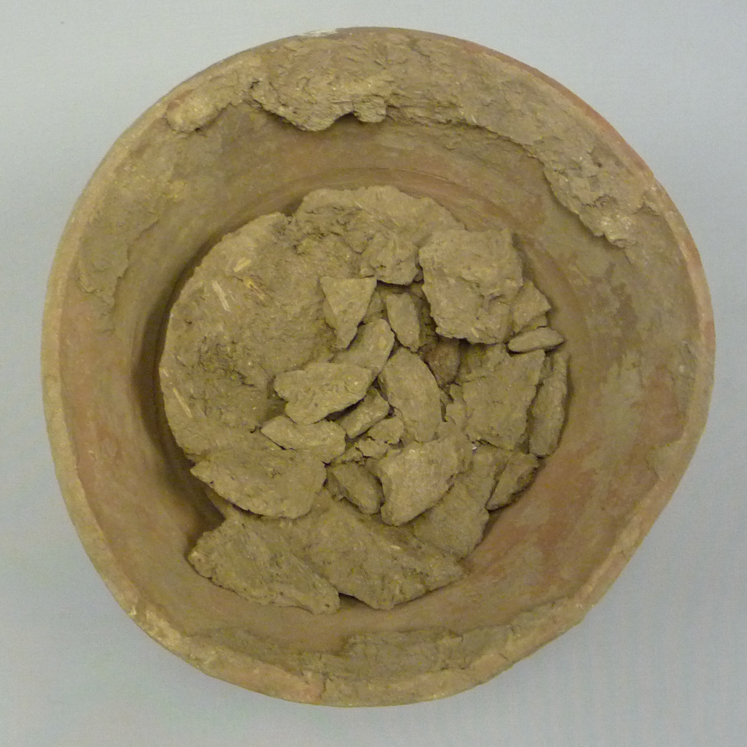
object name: bowl, mortar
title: Large Bowl of Mud Mortar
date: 1479-1458 BCE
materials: mud, pottery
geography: egypt